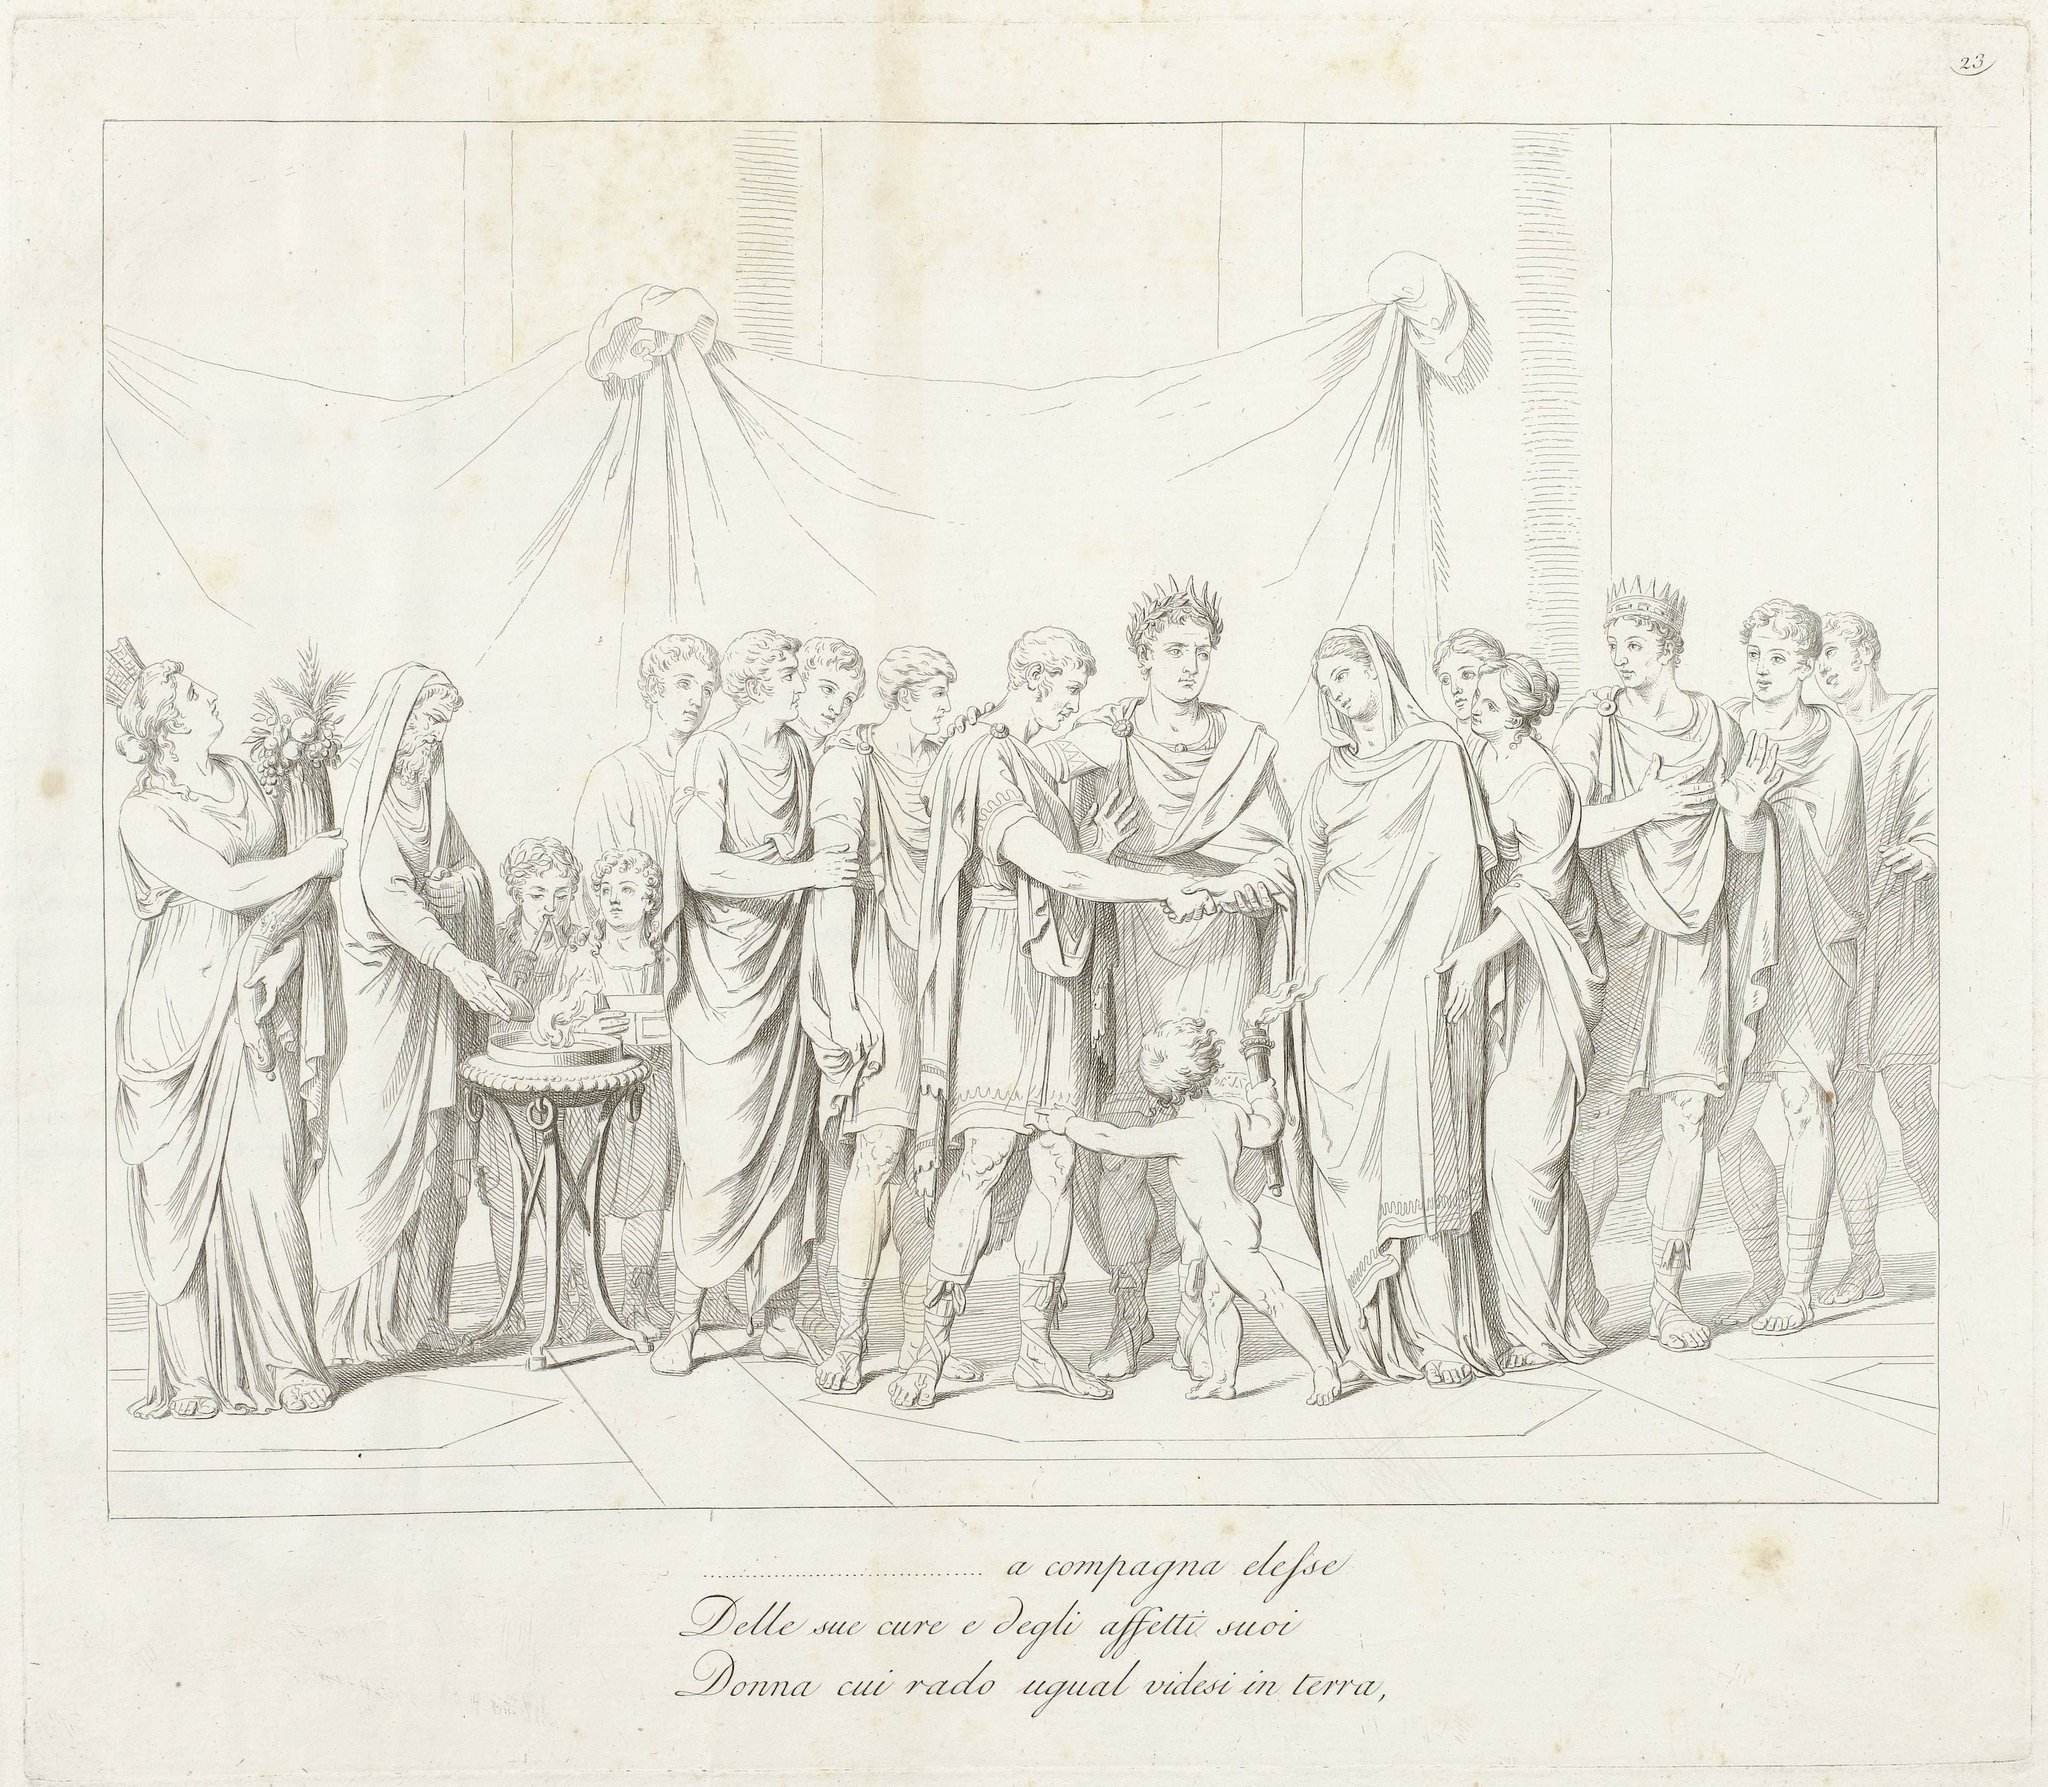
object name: album leaf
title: La pronea del Cesarotti delineata ed incisa dal Matteini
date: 1808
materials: paper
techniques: etching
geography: italy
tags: napoleon i (emperor of the french), ruler, sovereign, (civil) marriage ceremonies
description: Onder de voorstelling een versregel in het Italiaans. Prent maakt deel uit van een album.